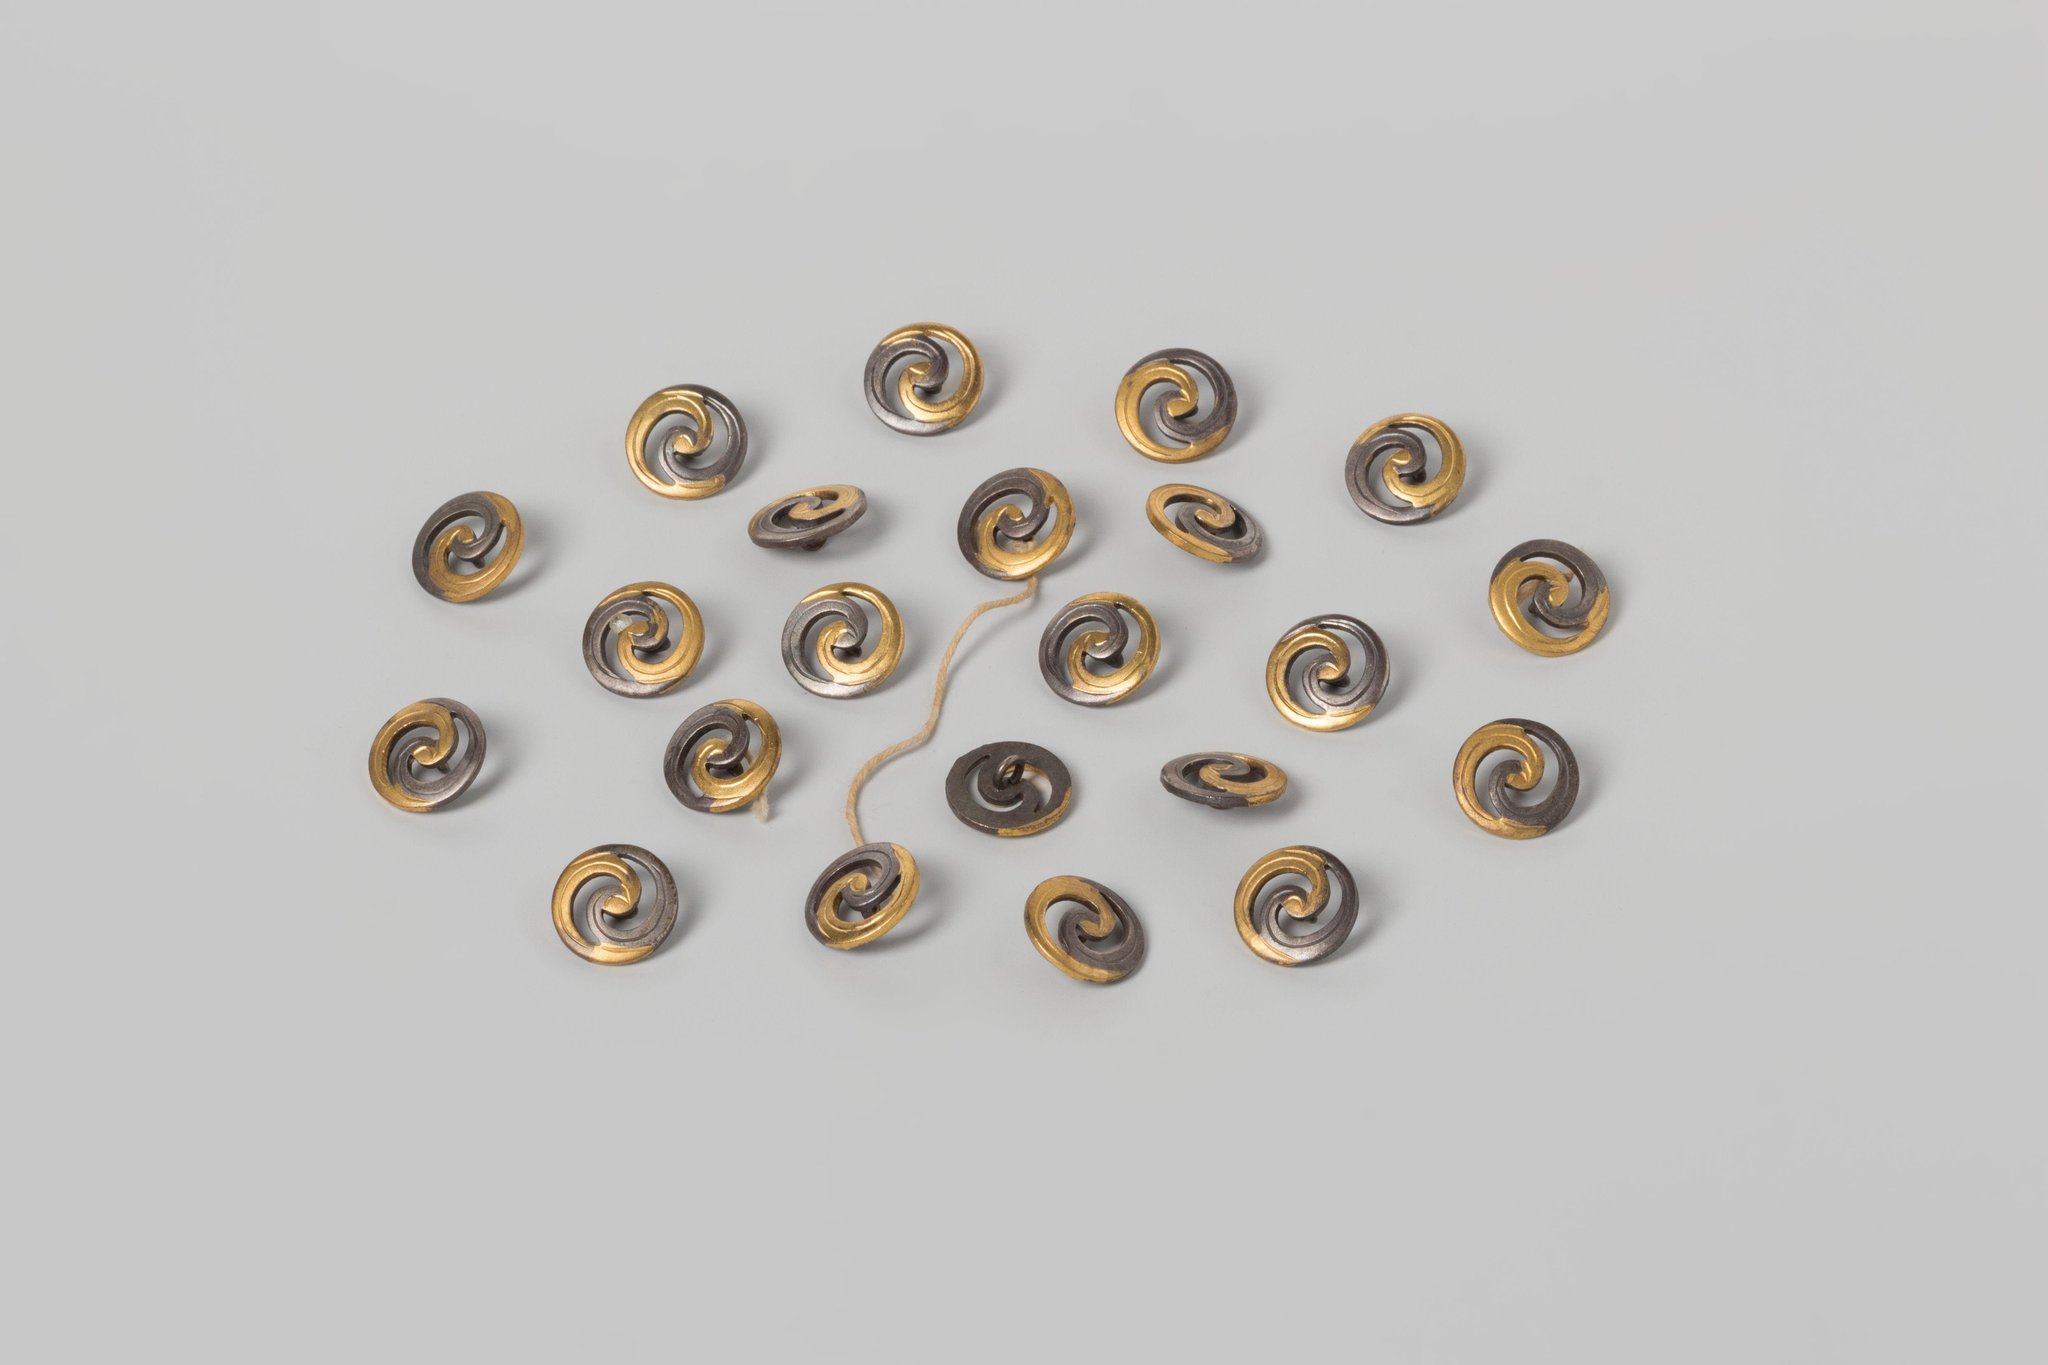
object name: button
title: Knoop, plat en rond, van gedeeltelijk met goudverf beschilderd metaal met krulmotief, gelijkend yin en yang, opengewerkt en gegraveerd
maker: Anonymous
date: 1880-1940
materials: paint, metal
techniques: embroidery, engraving, painting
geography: europe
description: Knoop, plat en rond, van gedeeltelijk met goudverf beschilderd metaal met krulmotief, gelijkend yin en yang, opengewerkt en gegraveerd.